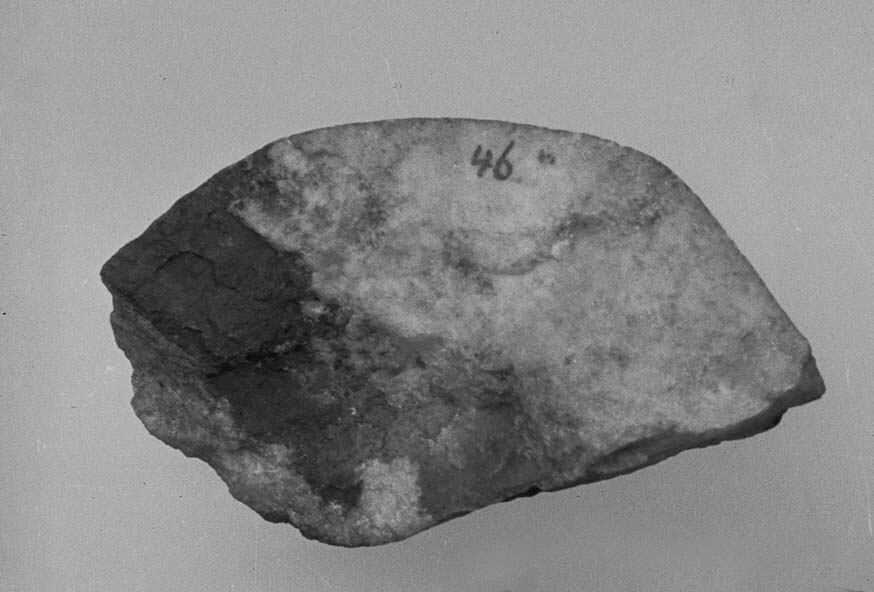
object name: fragment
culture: tibetan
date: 1902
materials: jade